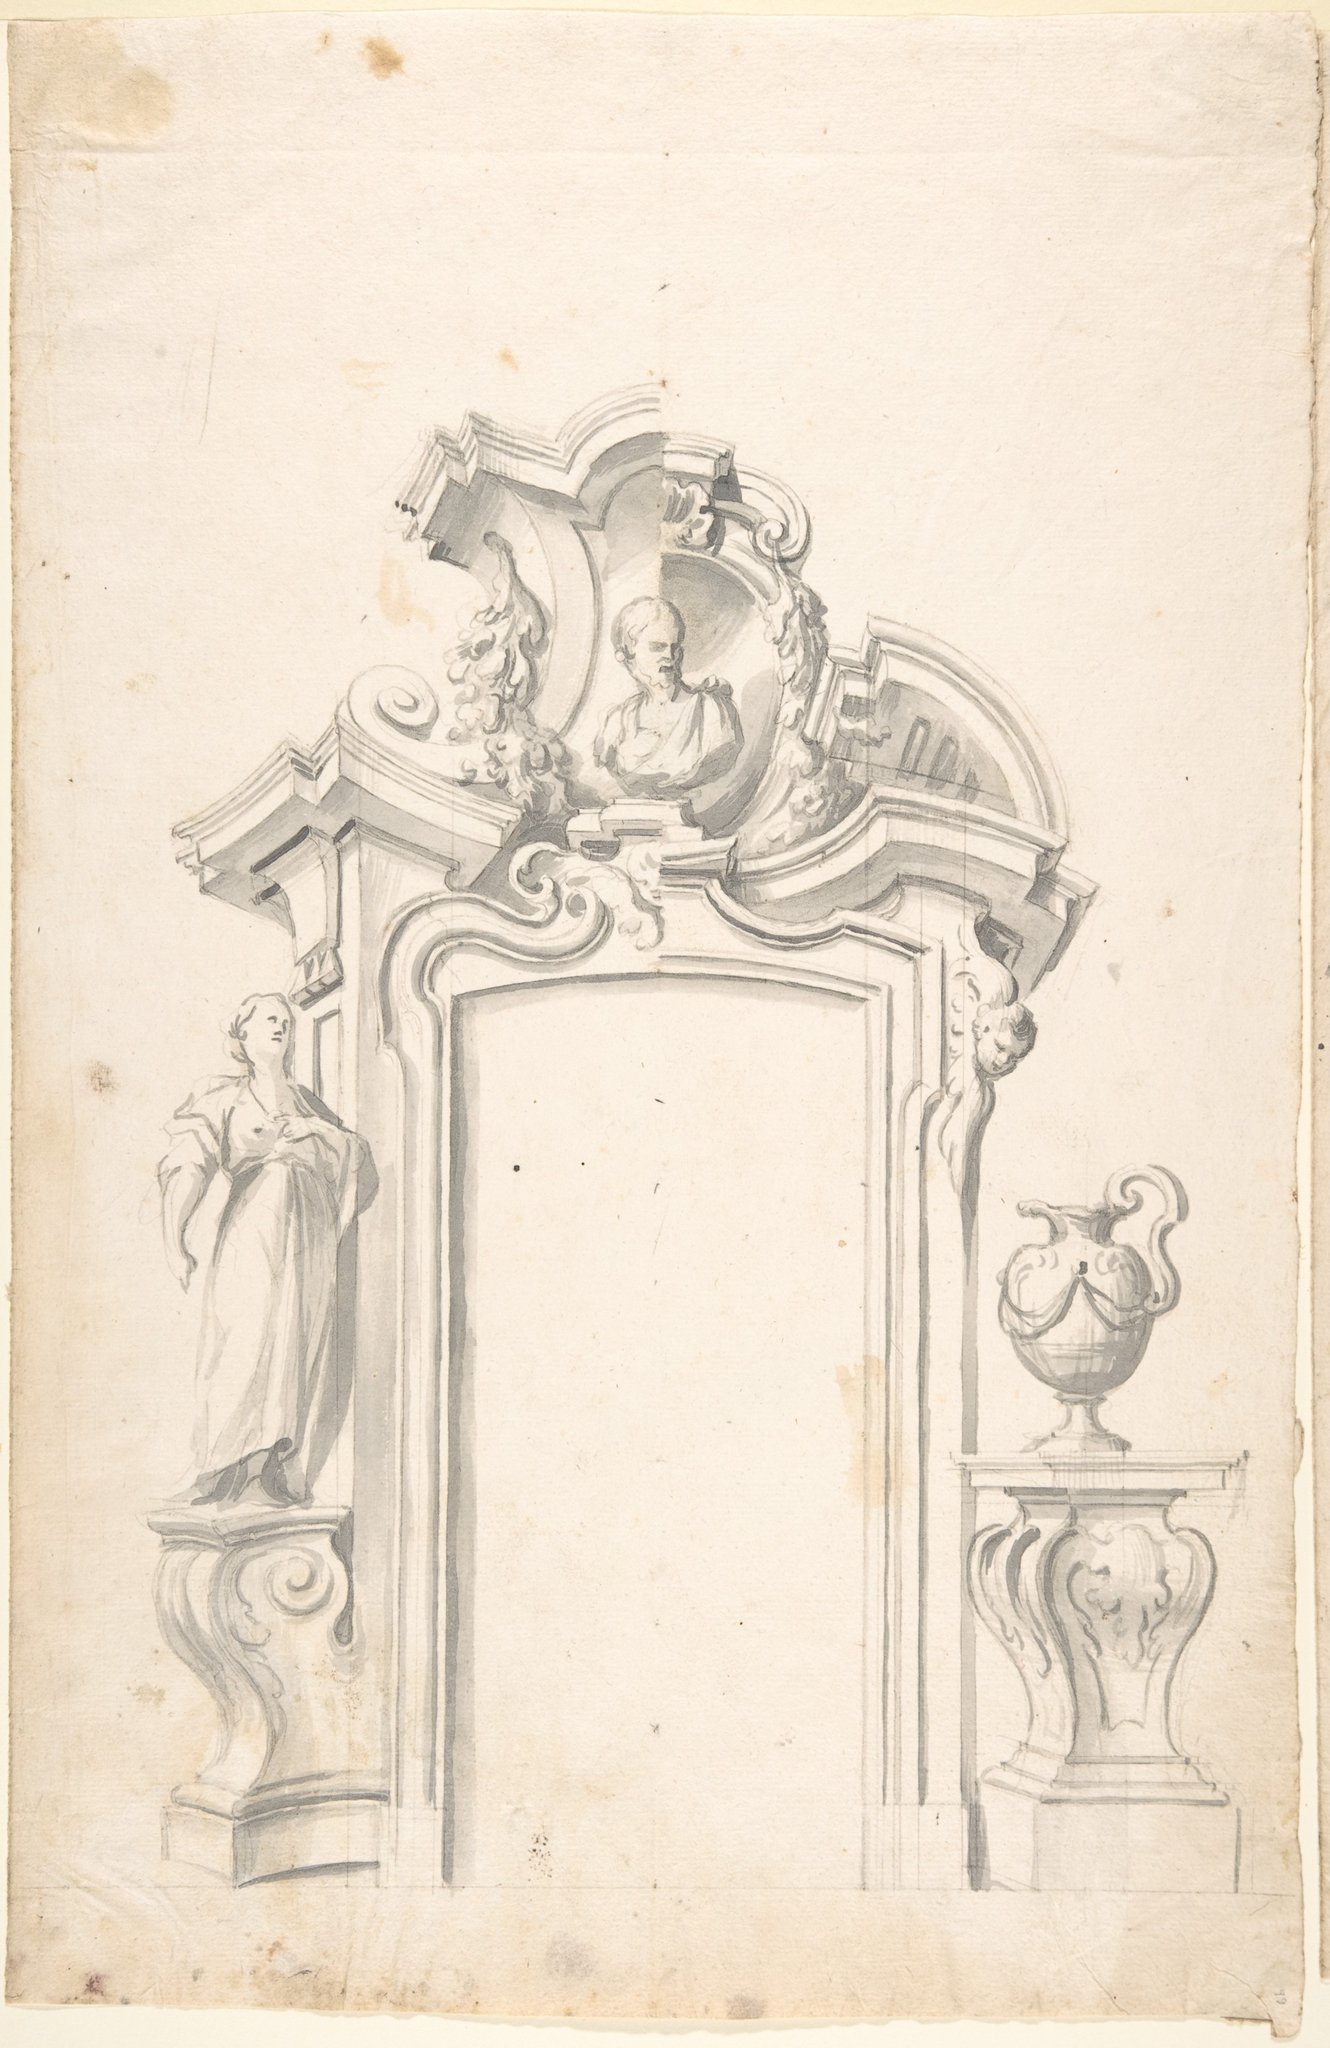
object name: drawing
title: Two Alternate Designs for a Doorway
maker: anonymous, italian, piedmontese, 18th century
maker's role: artist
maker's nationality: italian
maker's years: 1700-1800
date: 1700-1780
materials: graphite, drawing material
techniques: brush, wash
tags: architecture,doorways,women